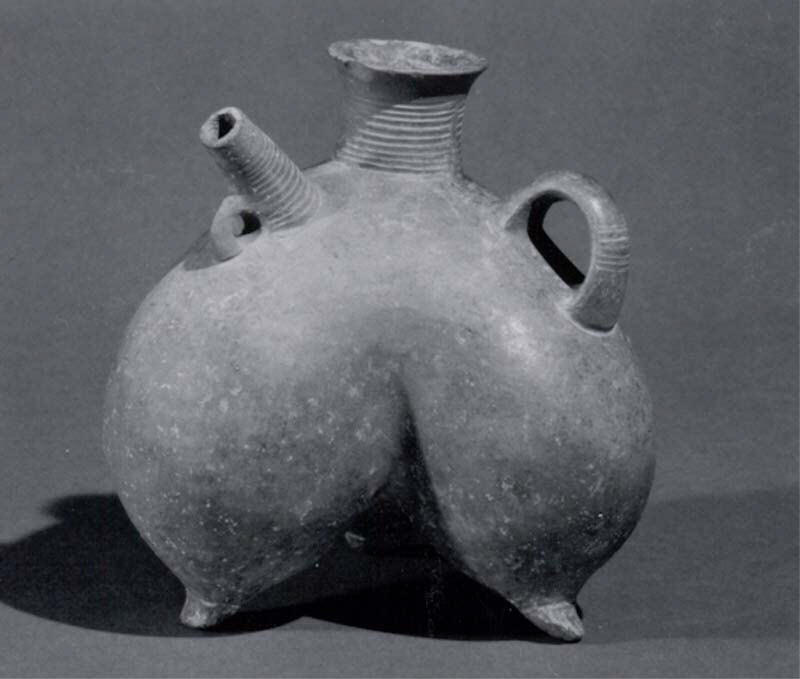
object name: pitcher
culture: iranian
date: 1000-1 BCE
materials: ceramic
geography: iran